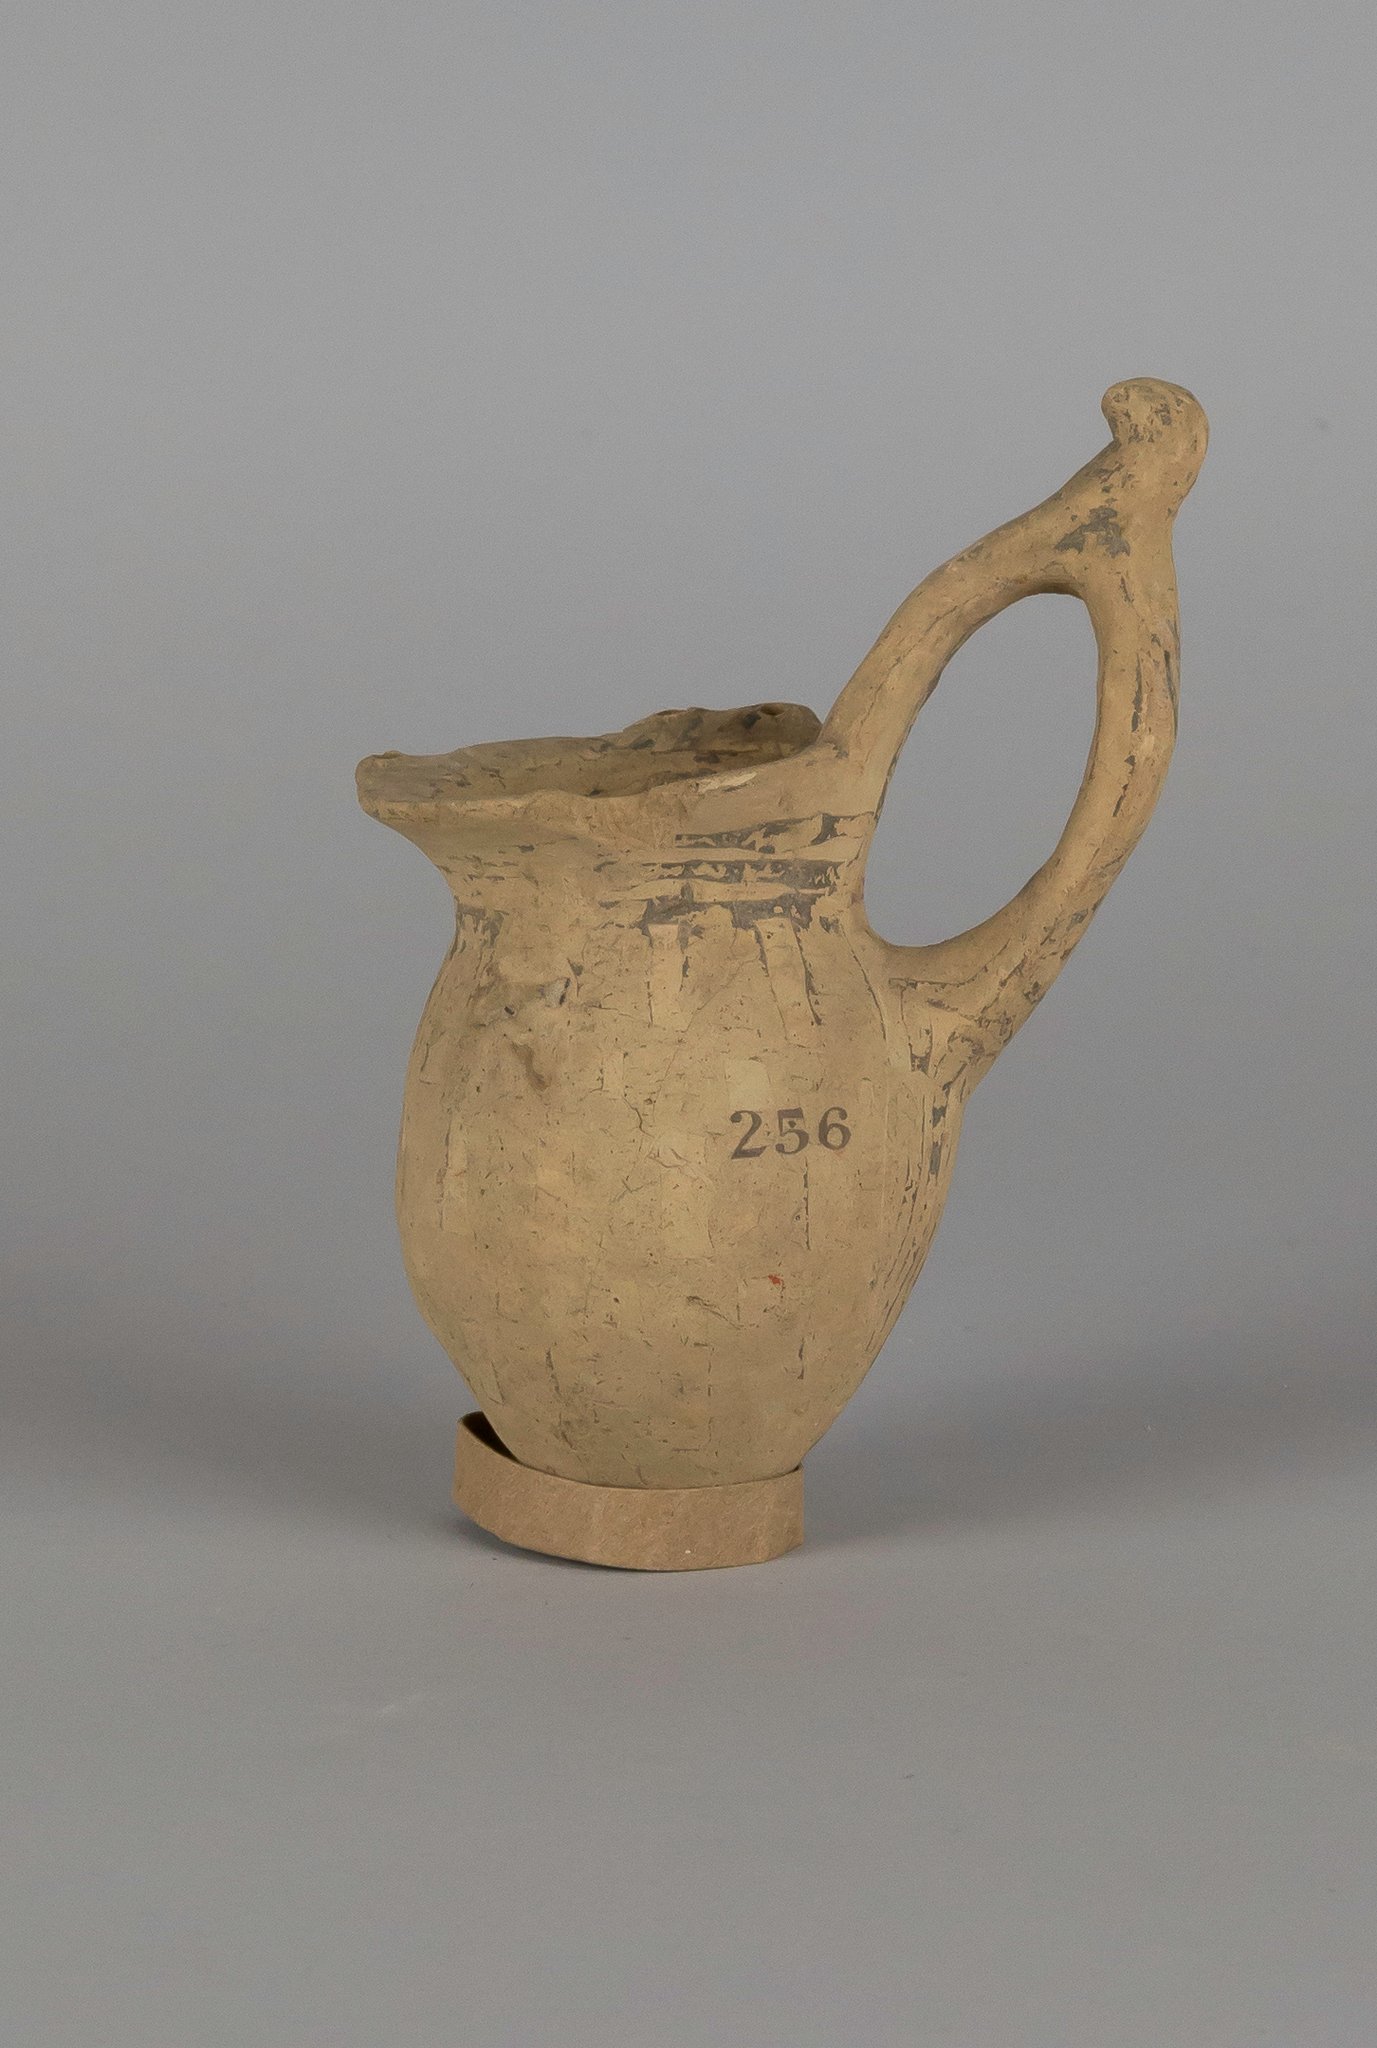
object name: jug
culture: cypriot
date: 3200-1050 BCE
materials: terracotta